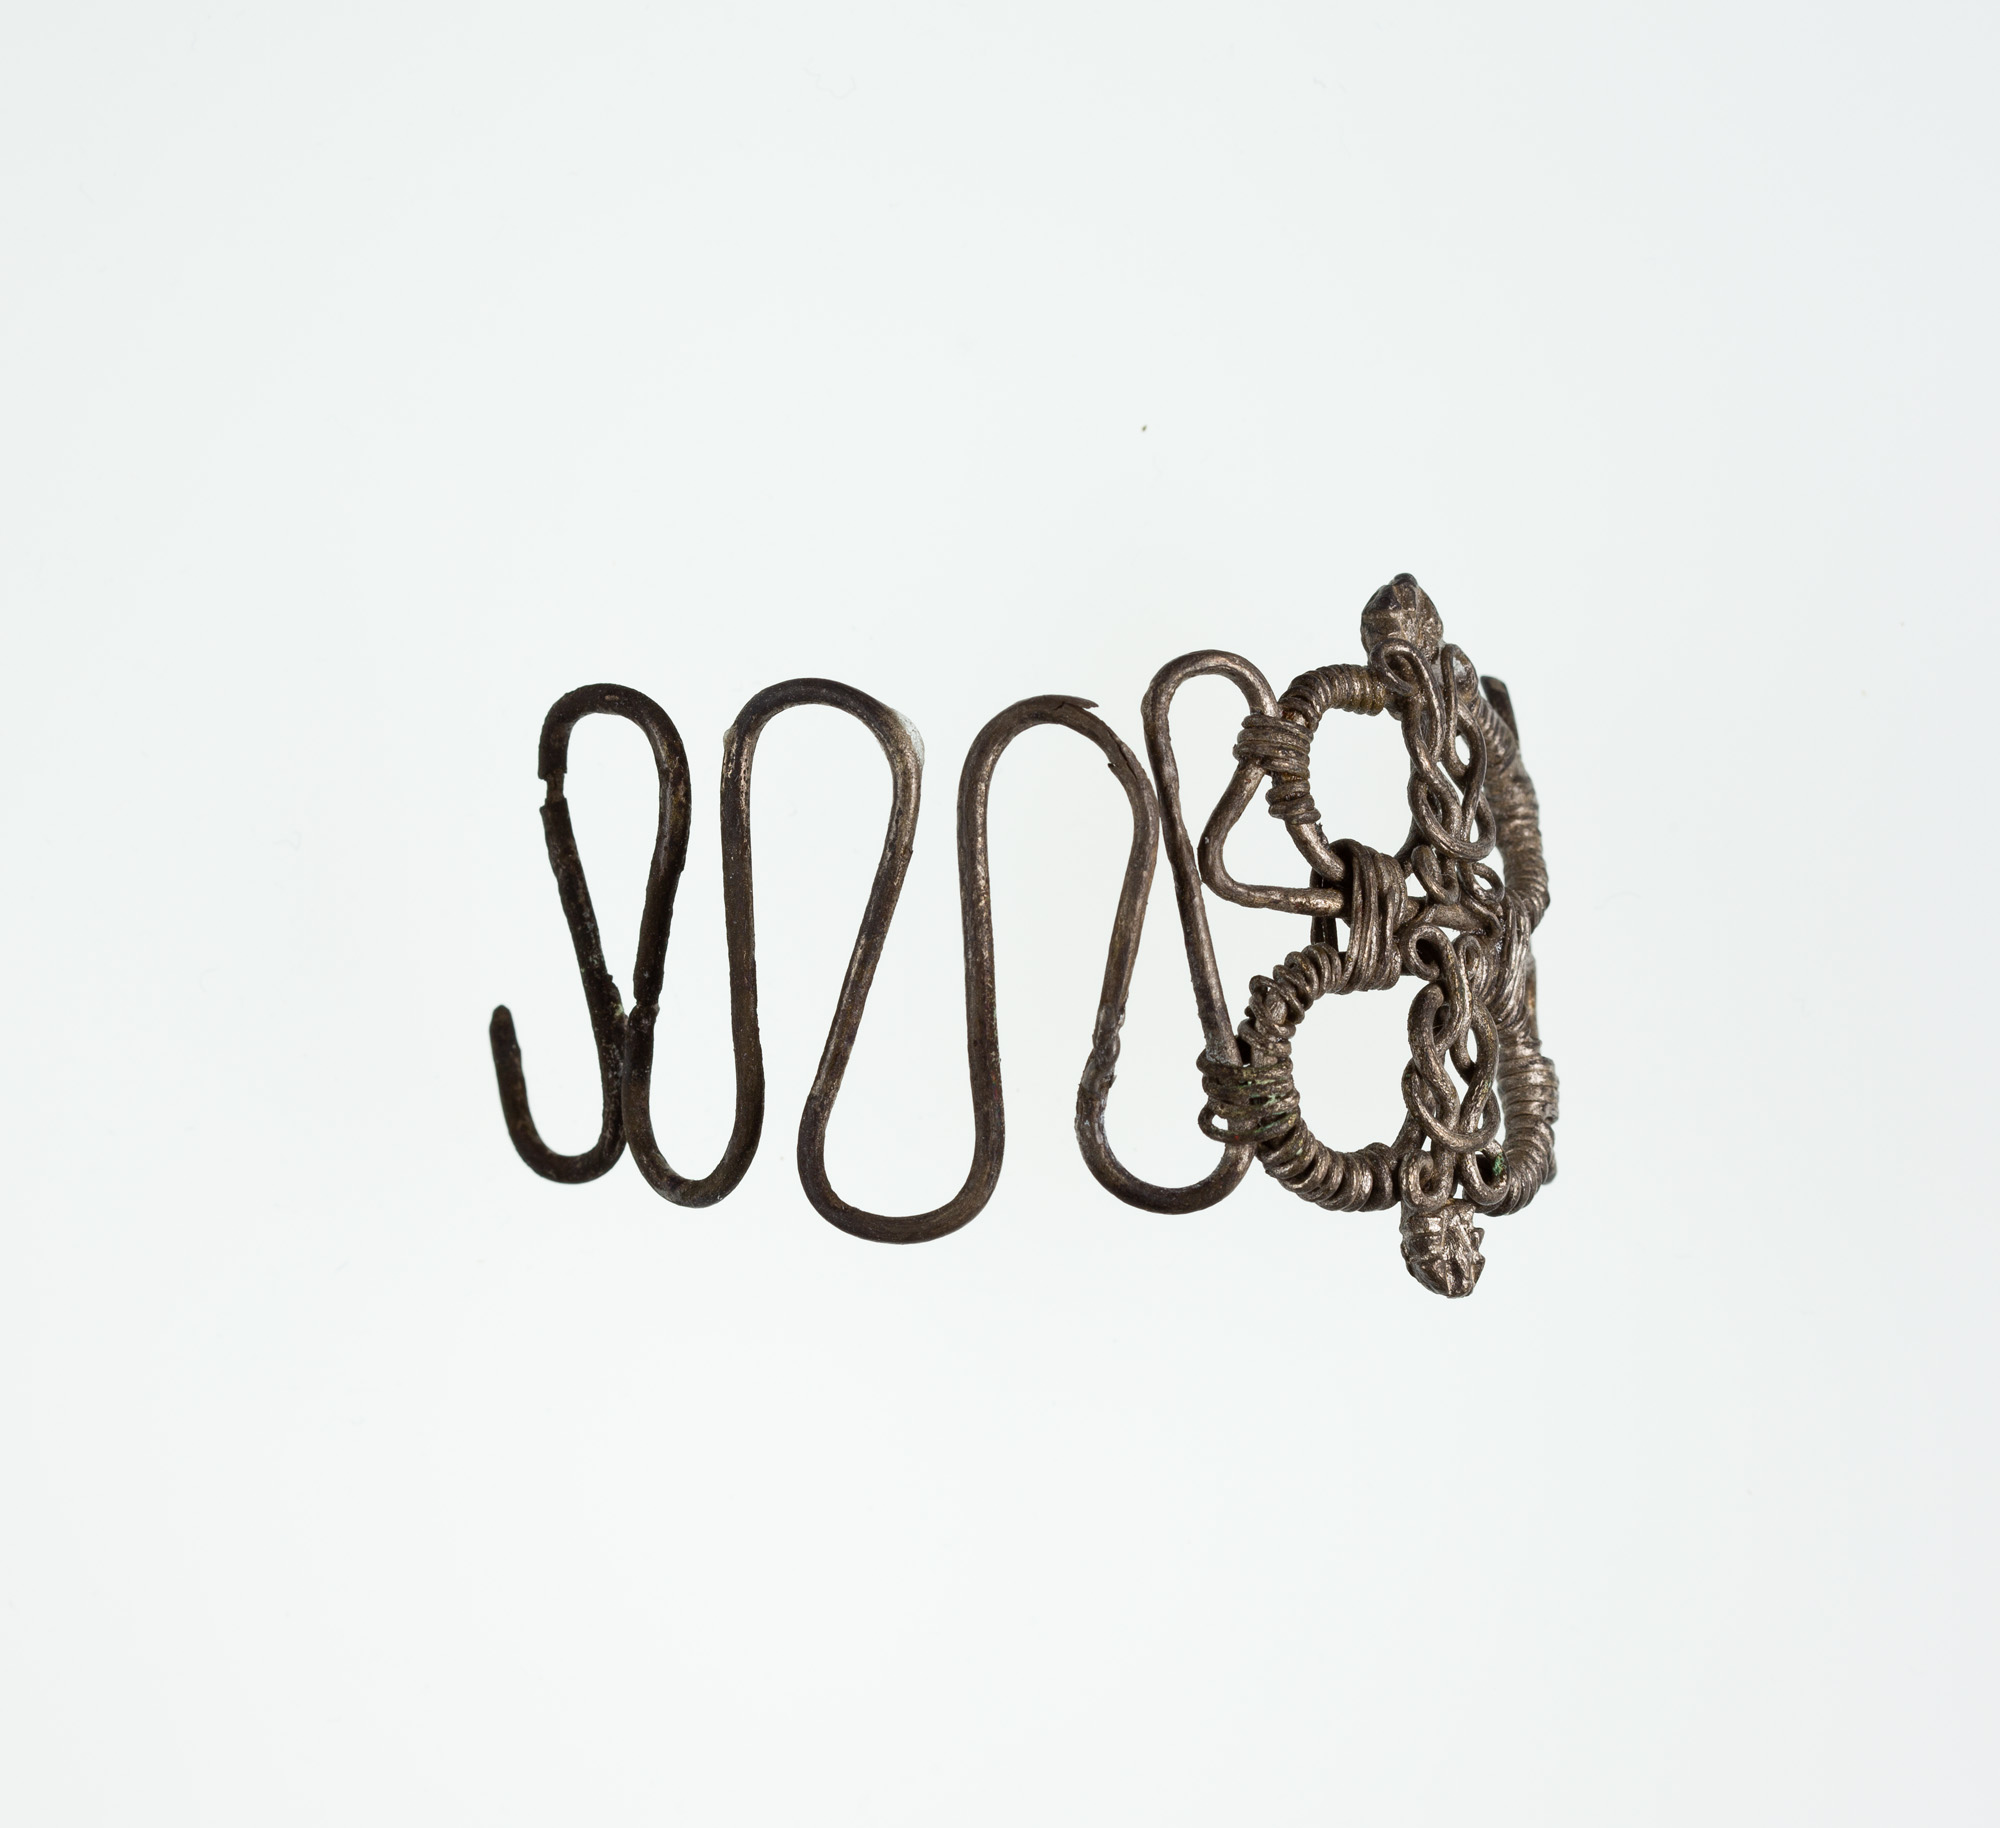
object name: bracelet fragment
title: Part (?) of a bracelet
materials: silver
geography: egypt